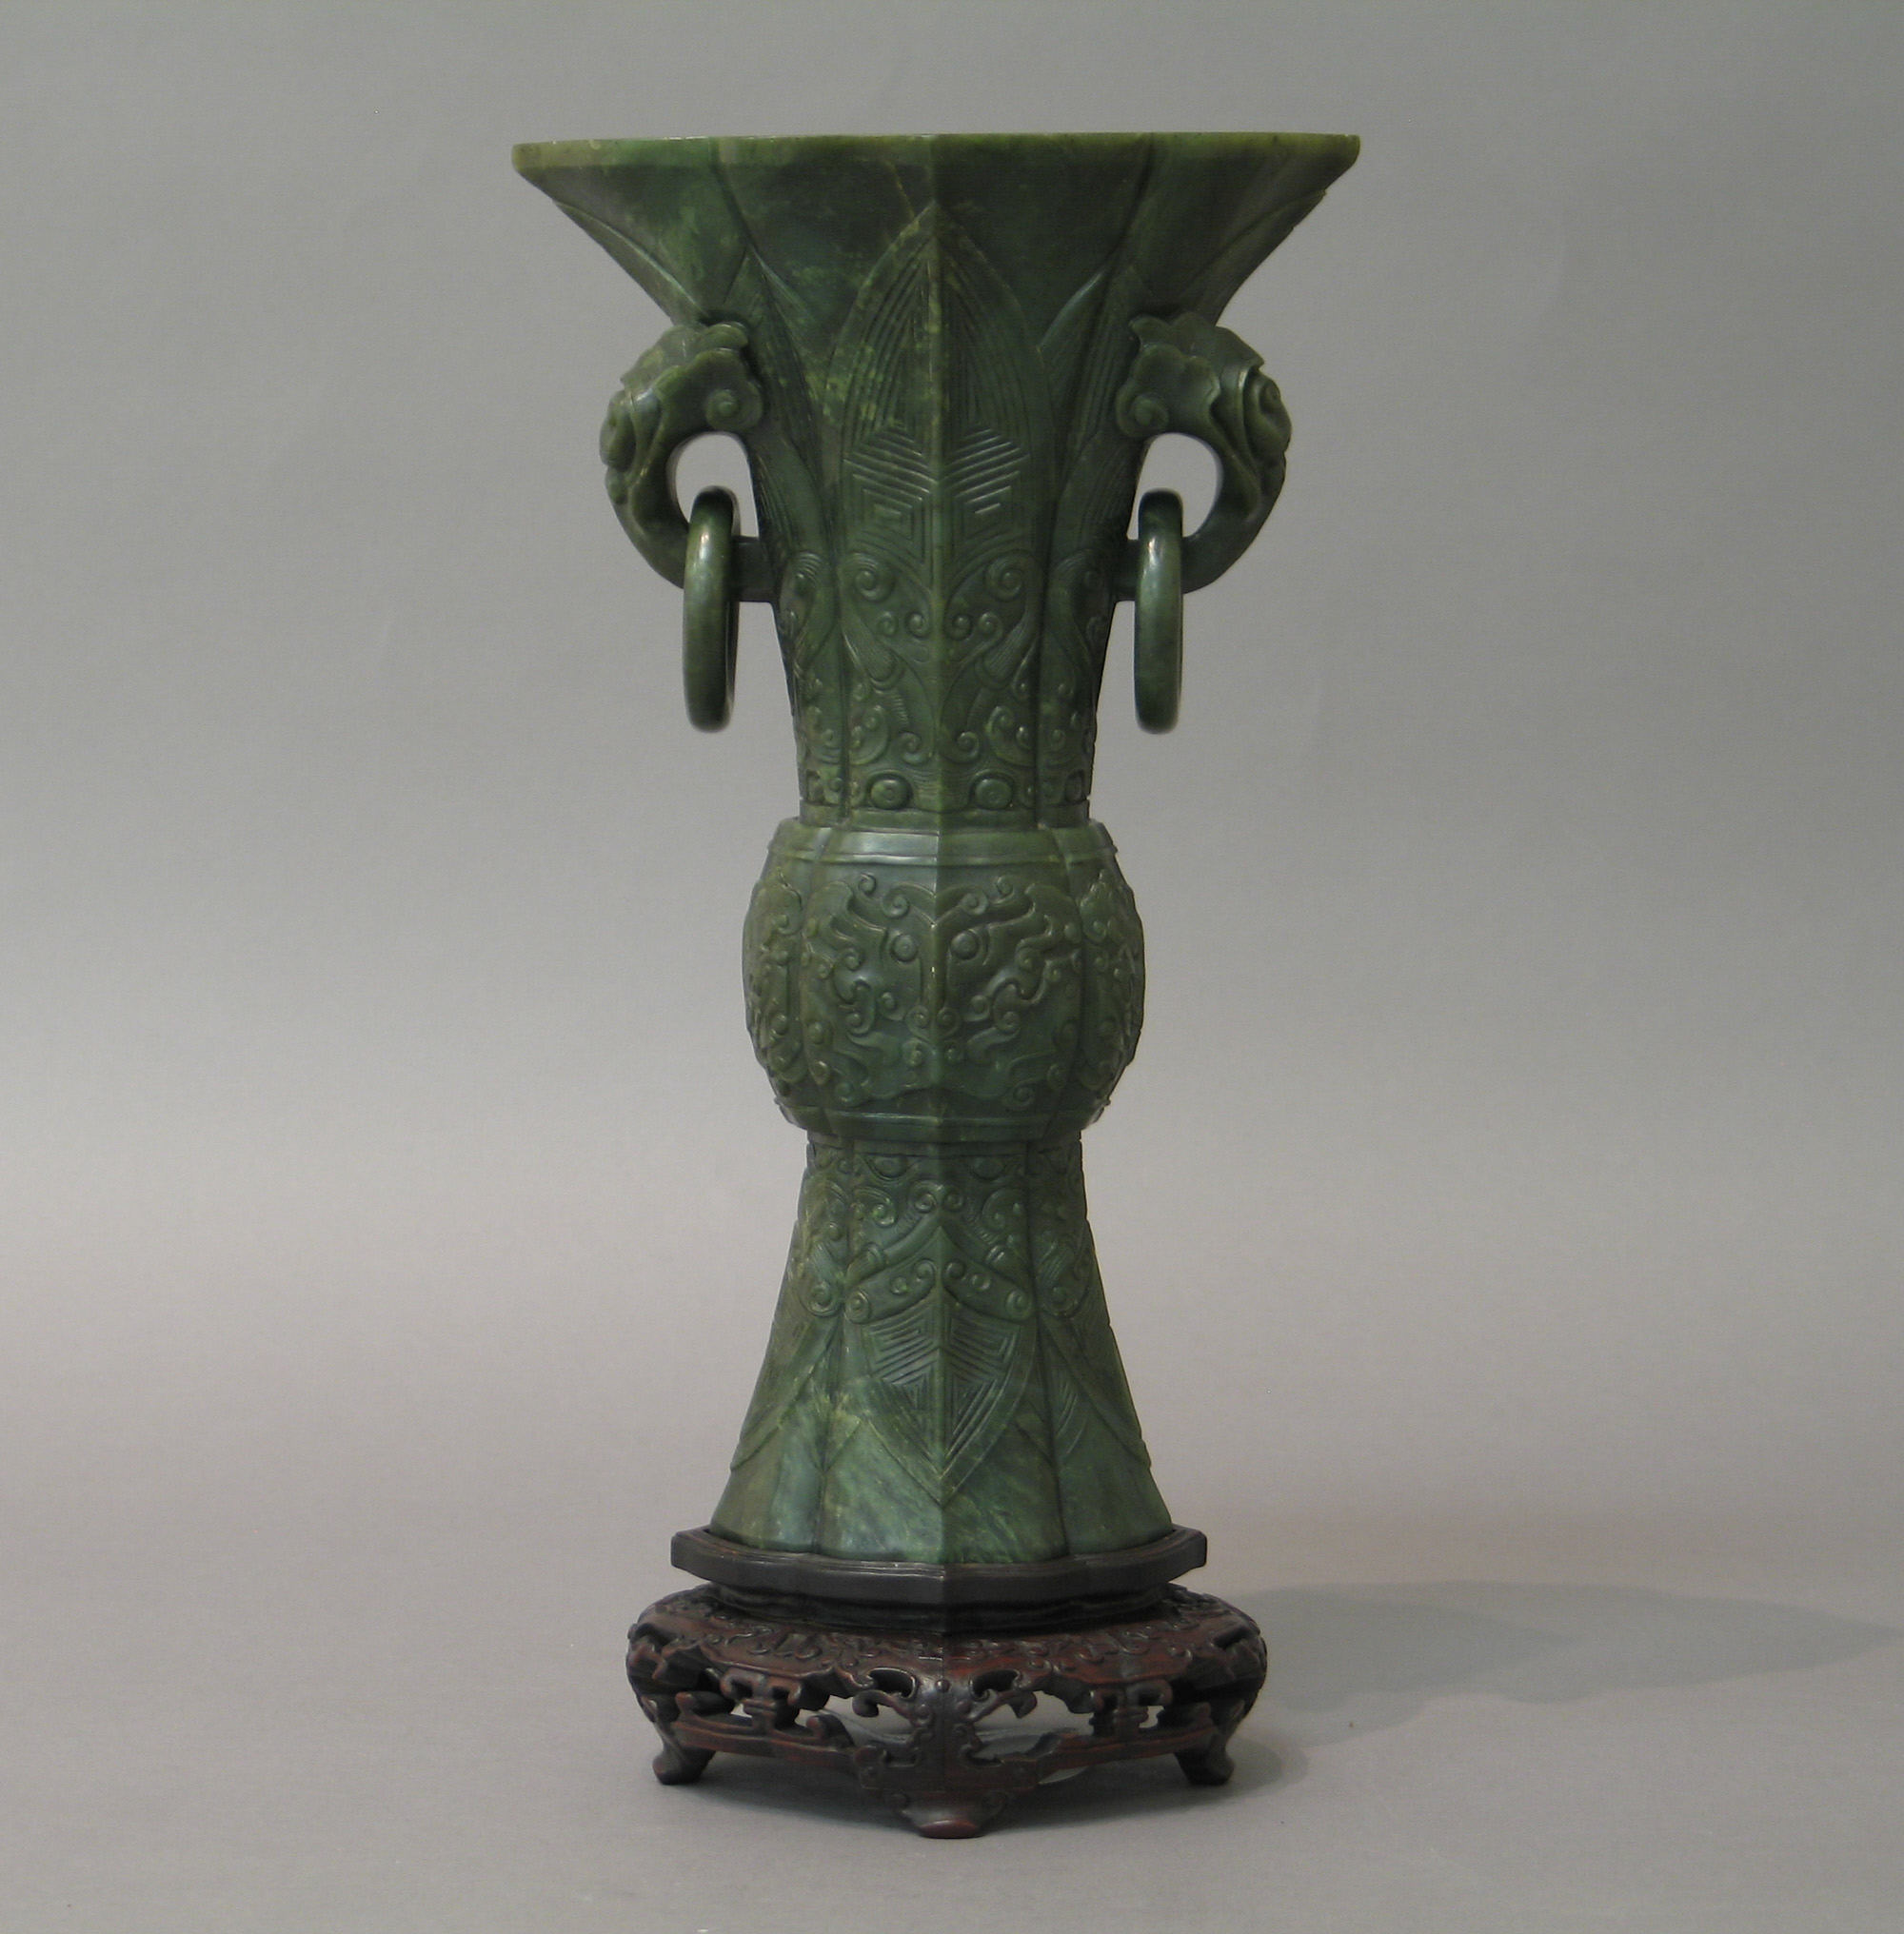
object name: beaker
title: Beaker of Ancient Bronze Design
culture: chinese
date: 1796-1820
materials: jade